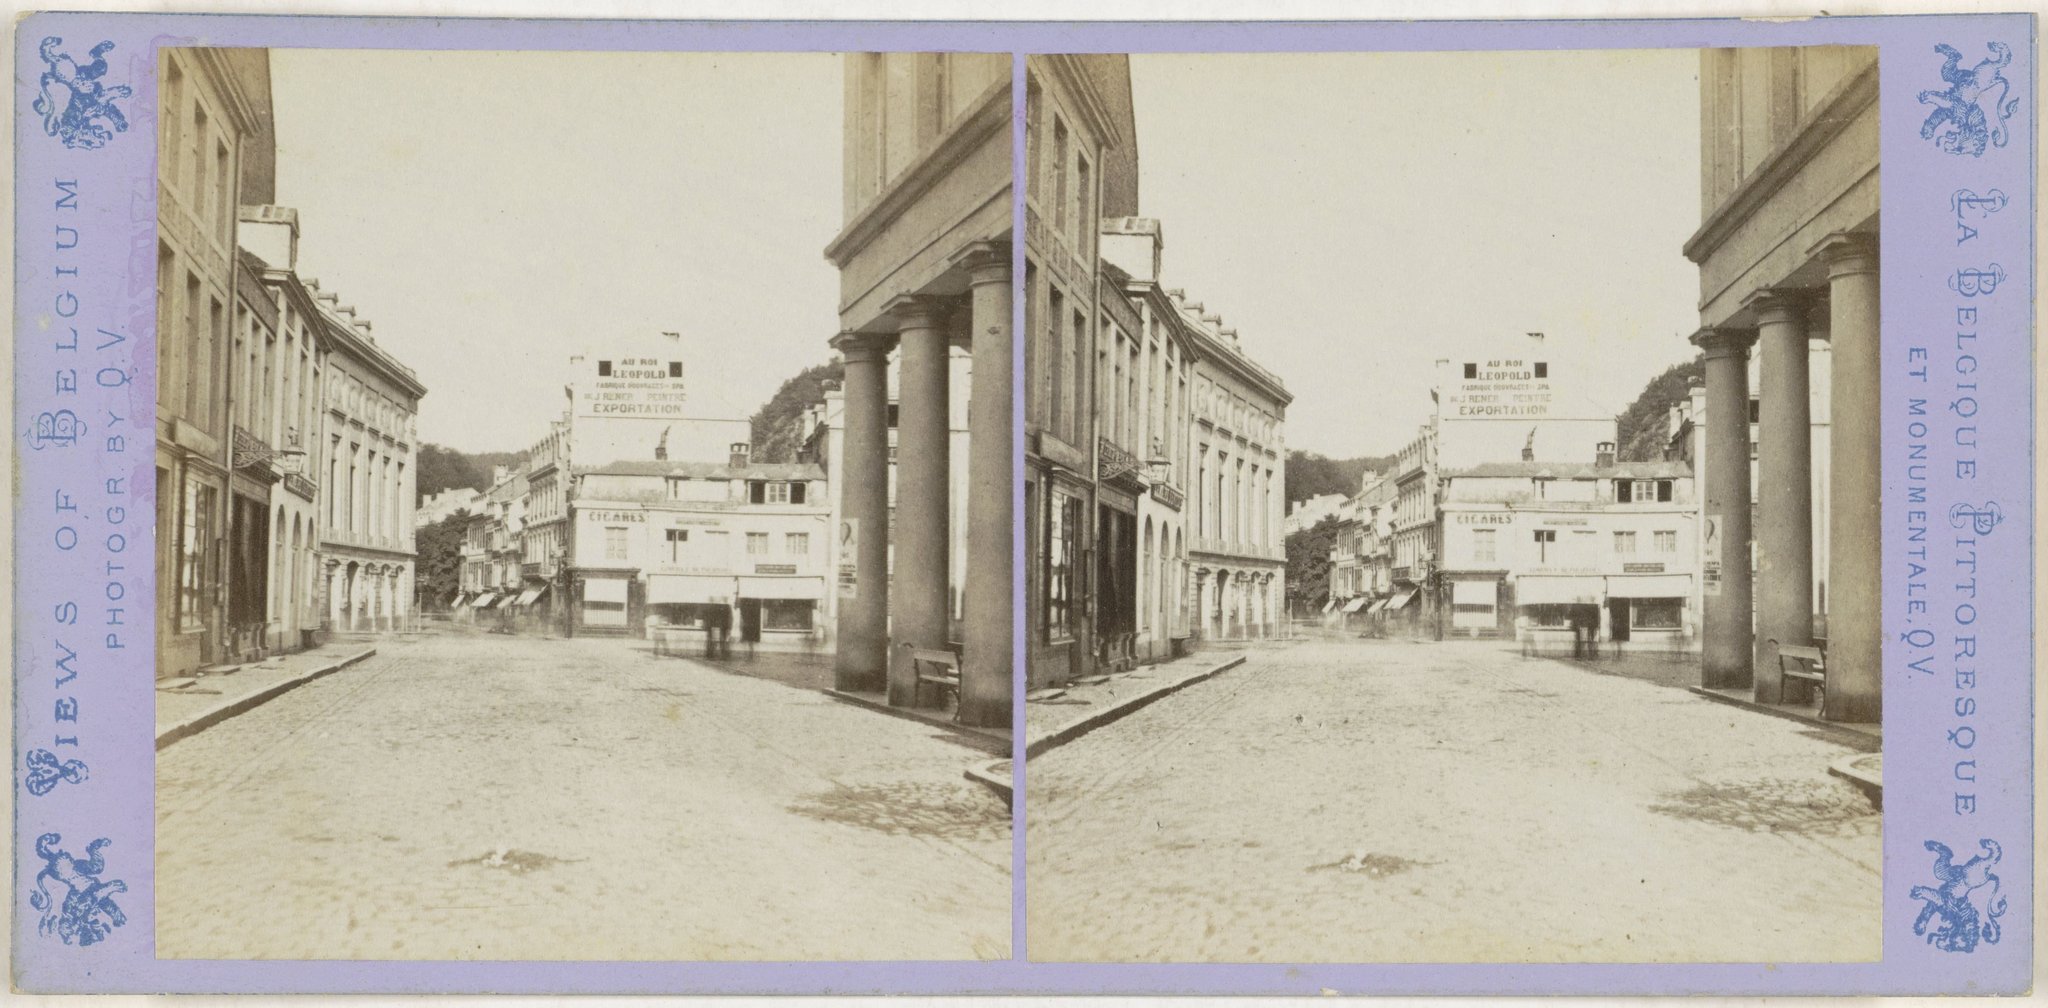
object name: stereograph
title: Spa, vue prise derrière le pouhon (la redoute et la rue royale)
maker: jules hippolyte quéval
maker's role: publisher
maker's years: 1824-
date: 1866-1870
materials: cardboard, paper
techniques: albumen print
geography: spa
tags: street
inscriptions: number: ‘No 1775’